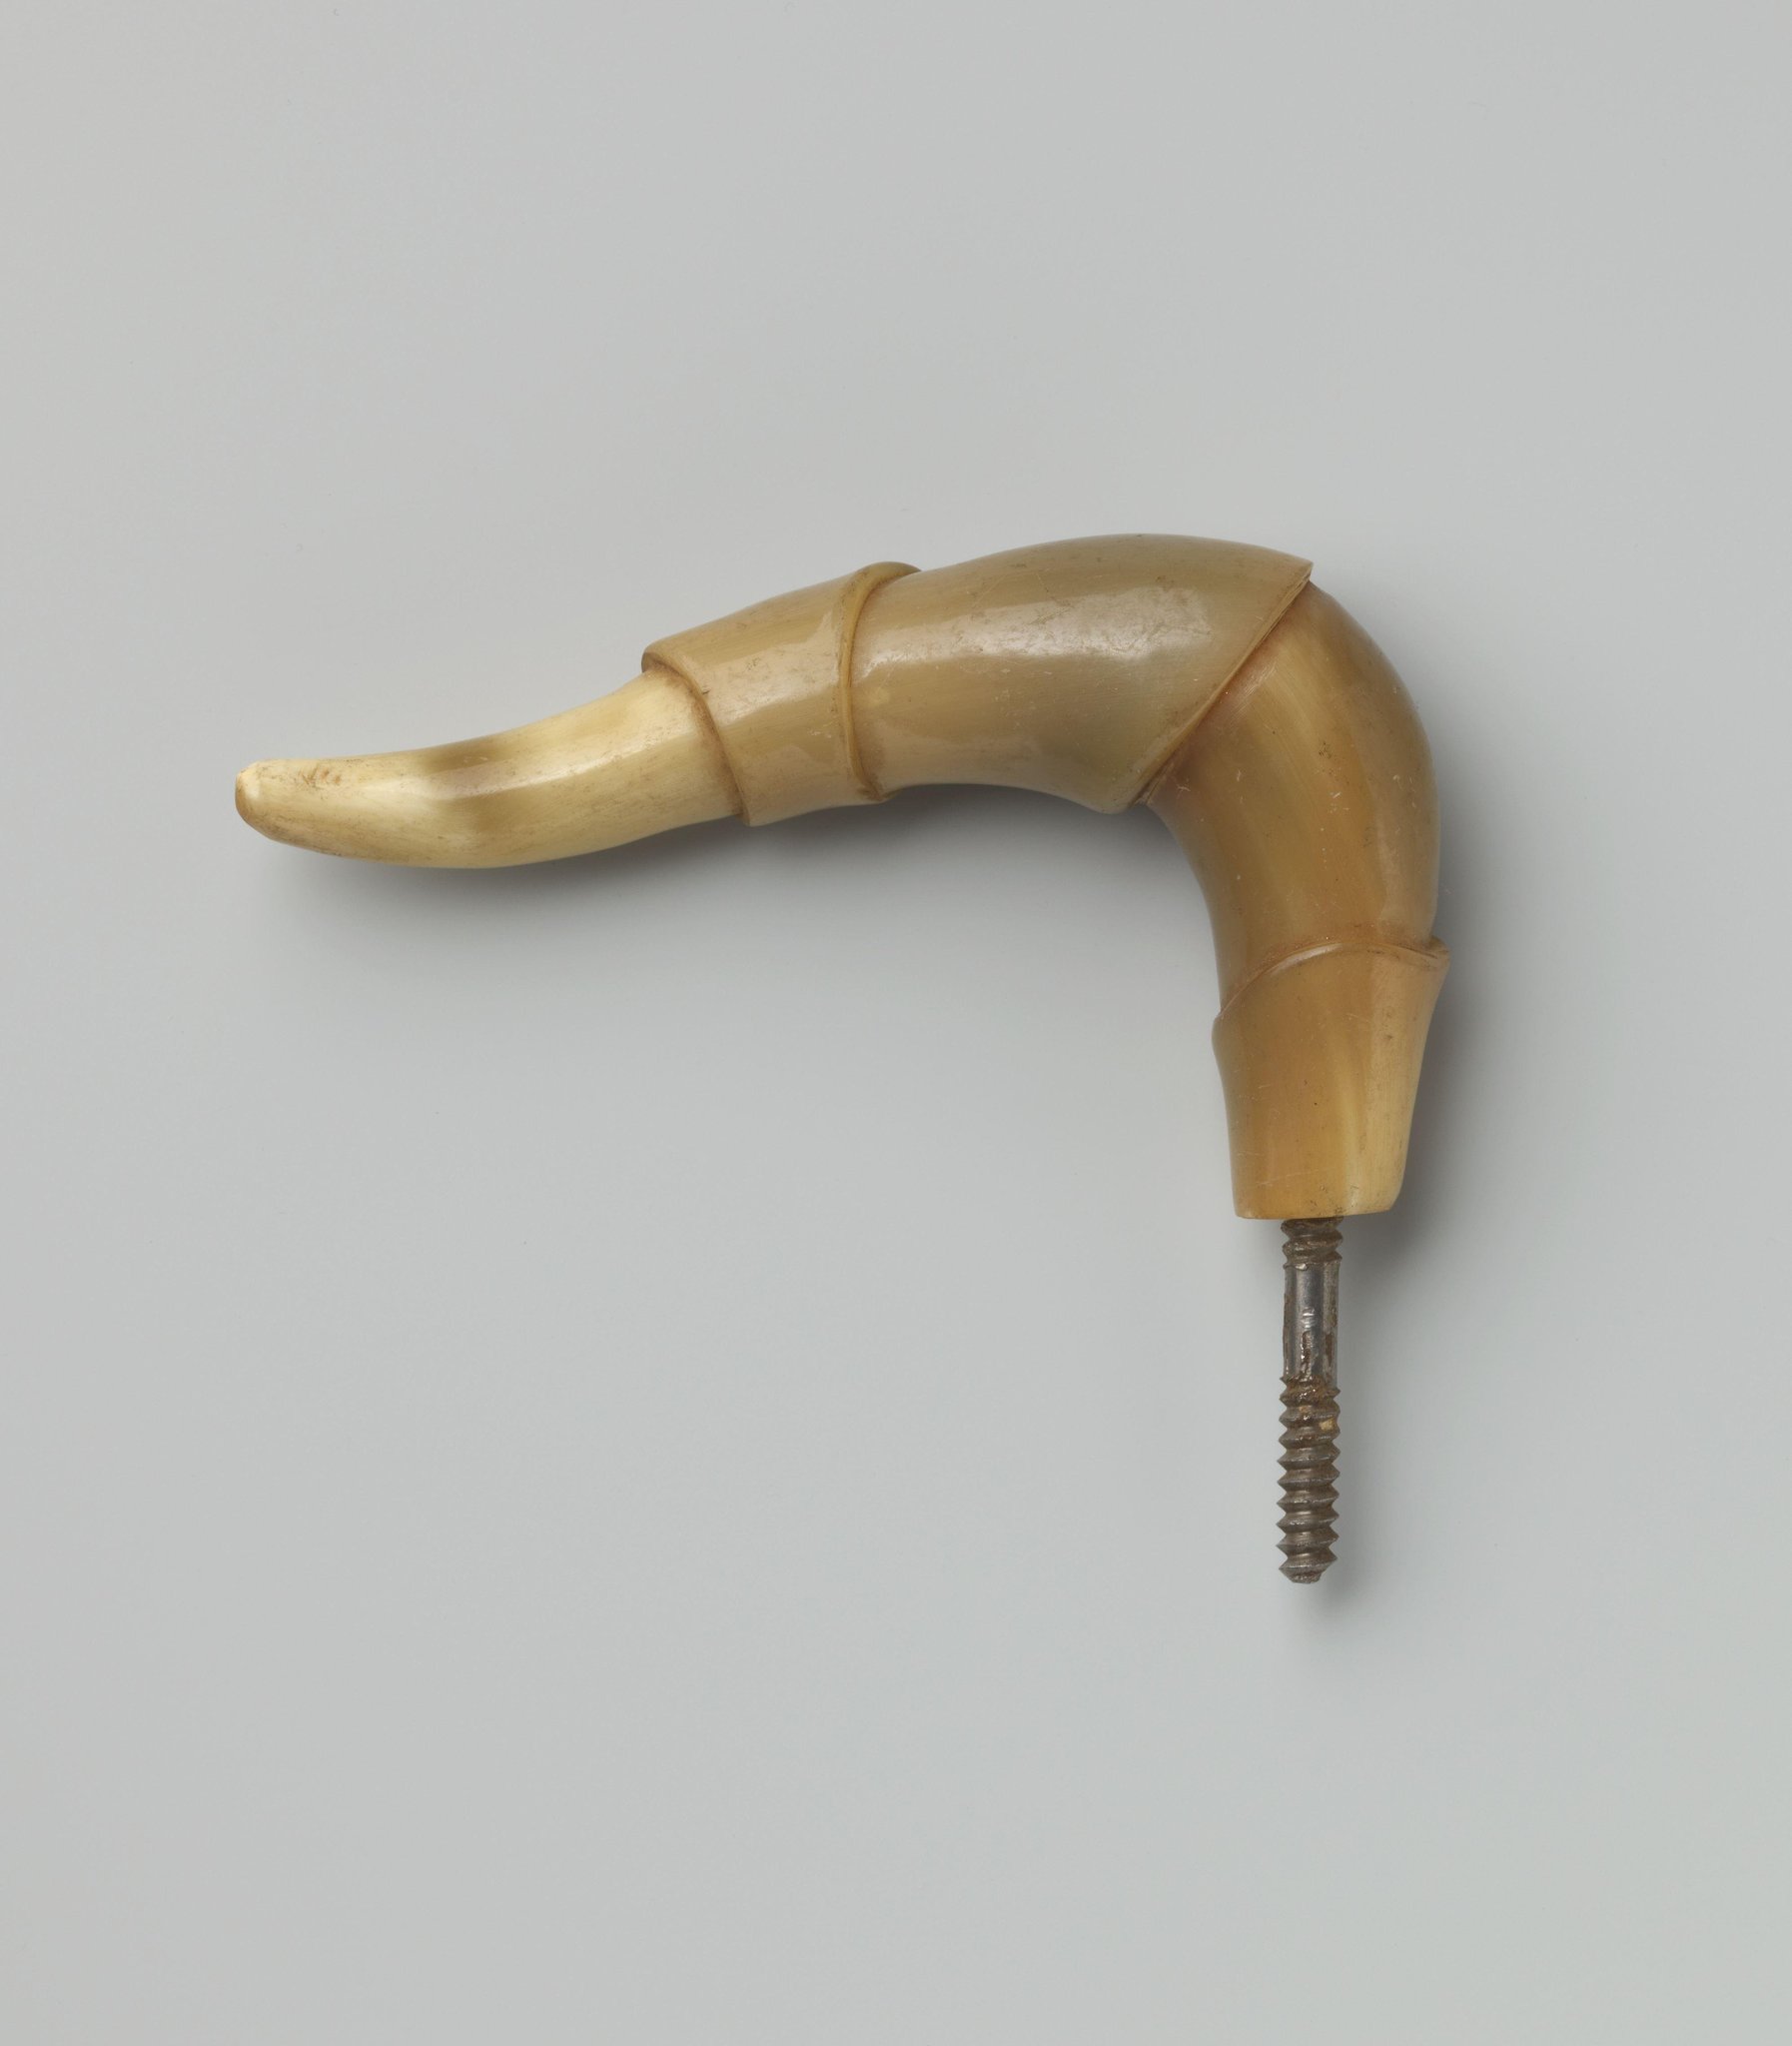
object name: haakknop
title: Knop van beige hoorn, gebogen, met drie verdikkingen, in een punt eindigend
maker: Anonymous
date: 1900-1930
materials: horn, metal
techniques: casting, cutting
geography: netherlands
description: Knop van beige hoorn, gebogen, met drie verdikkingen, in een punt eindigend, met schroefdraad.